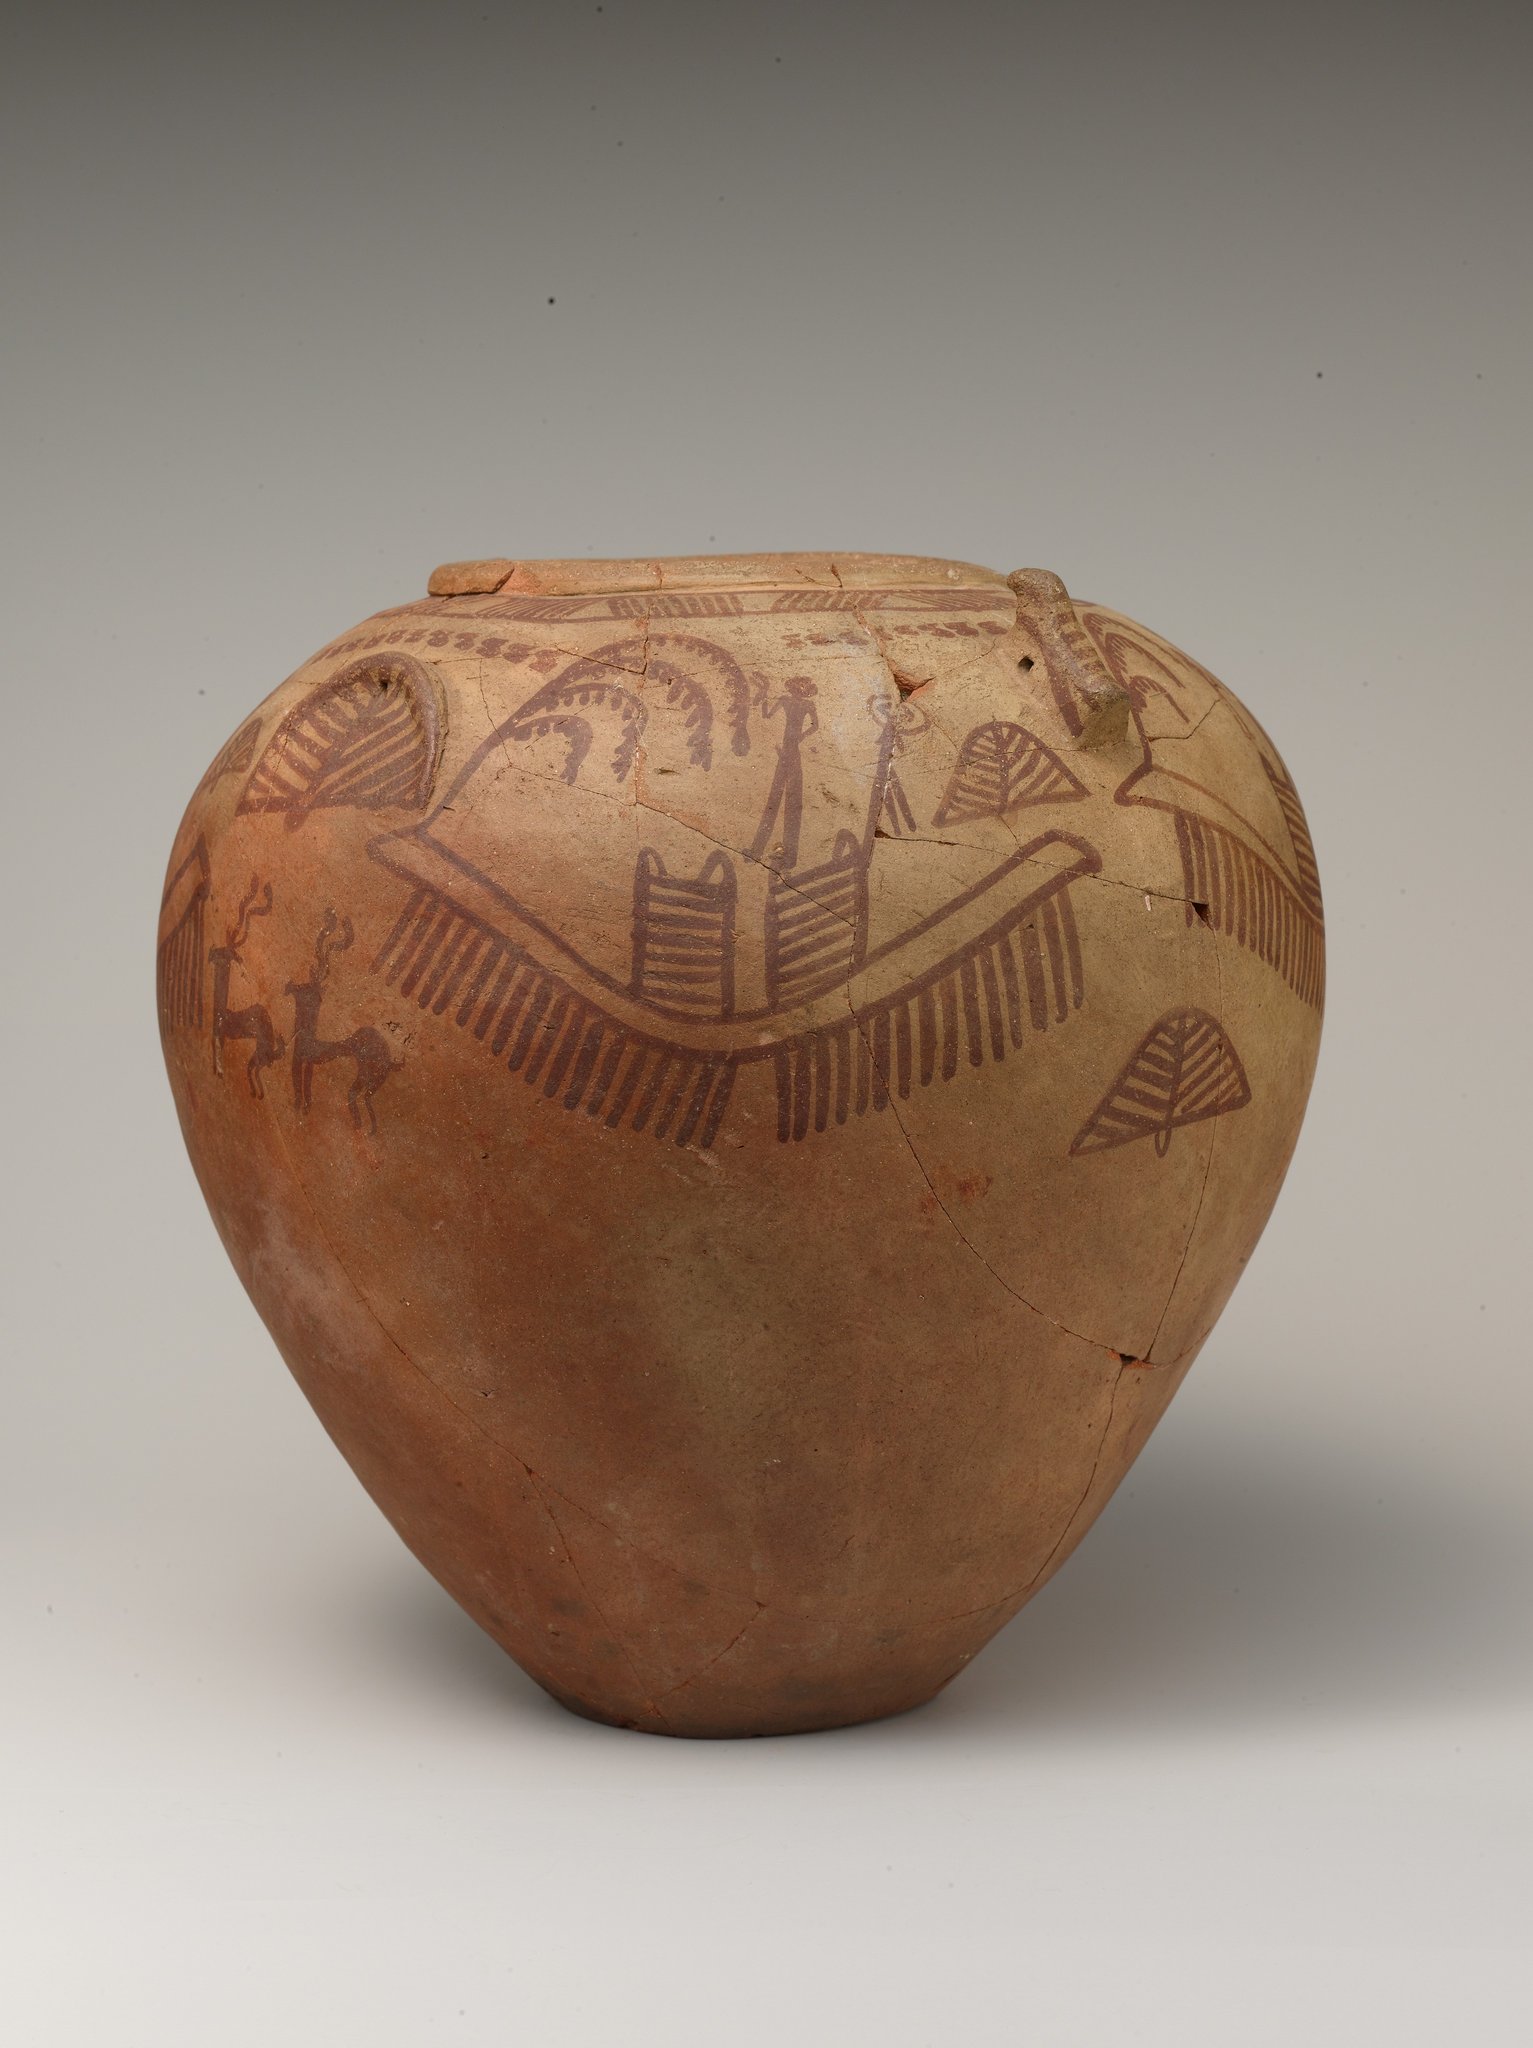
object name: jar, decorated ware, boat and figure, falcon lug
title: Decorated ware jar with boats and human figures and falcon-styled lugs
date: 3450-3300 BCE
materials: paint, pottery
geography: egypt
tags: boats